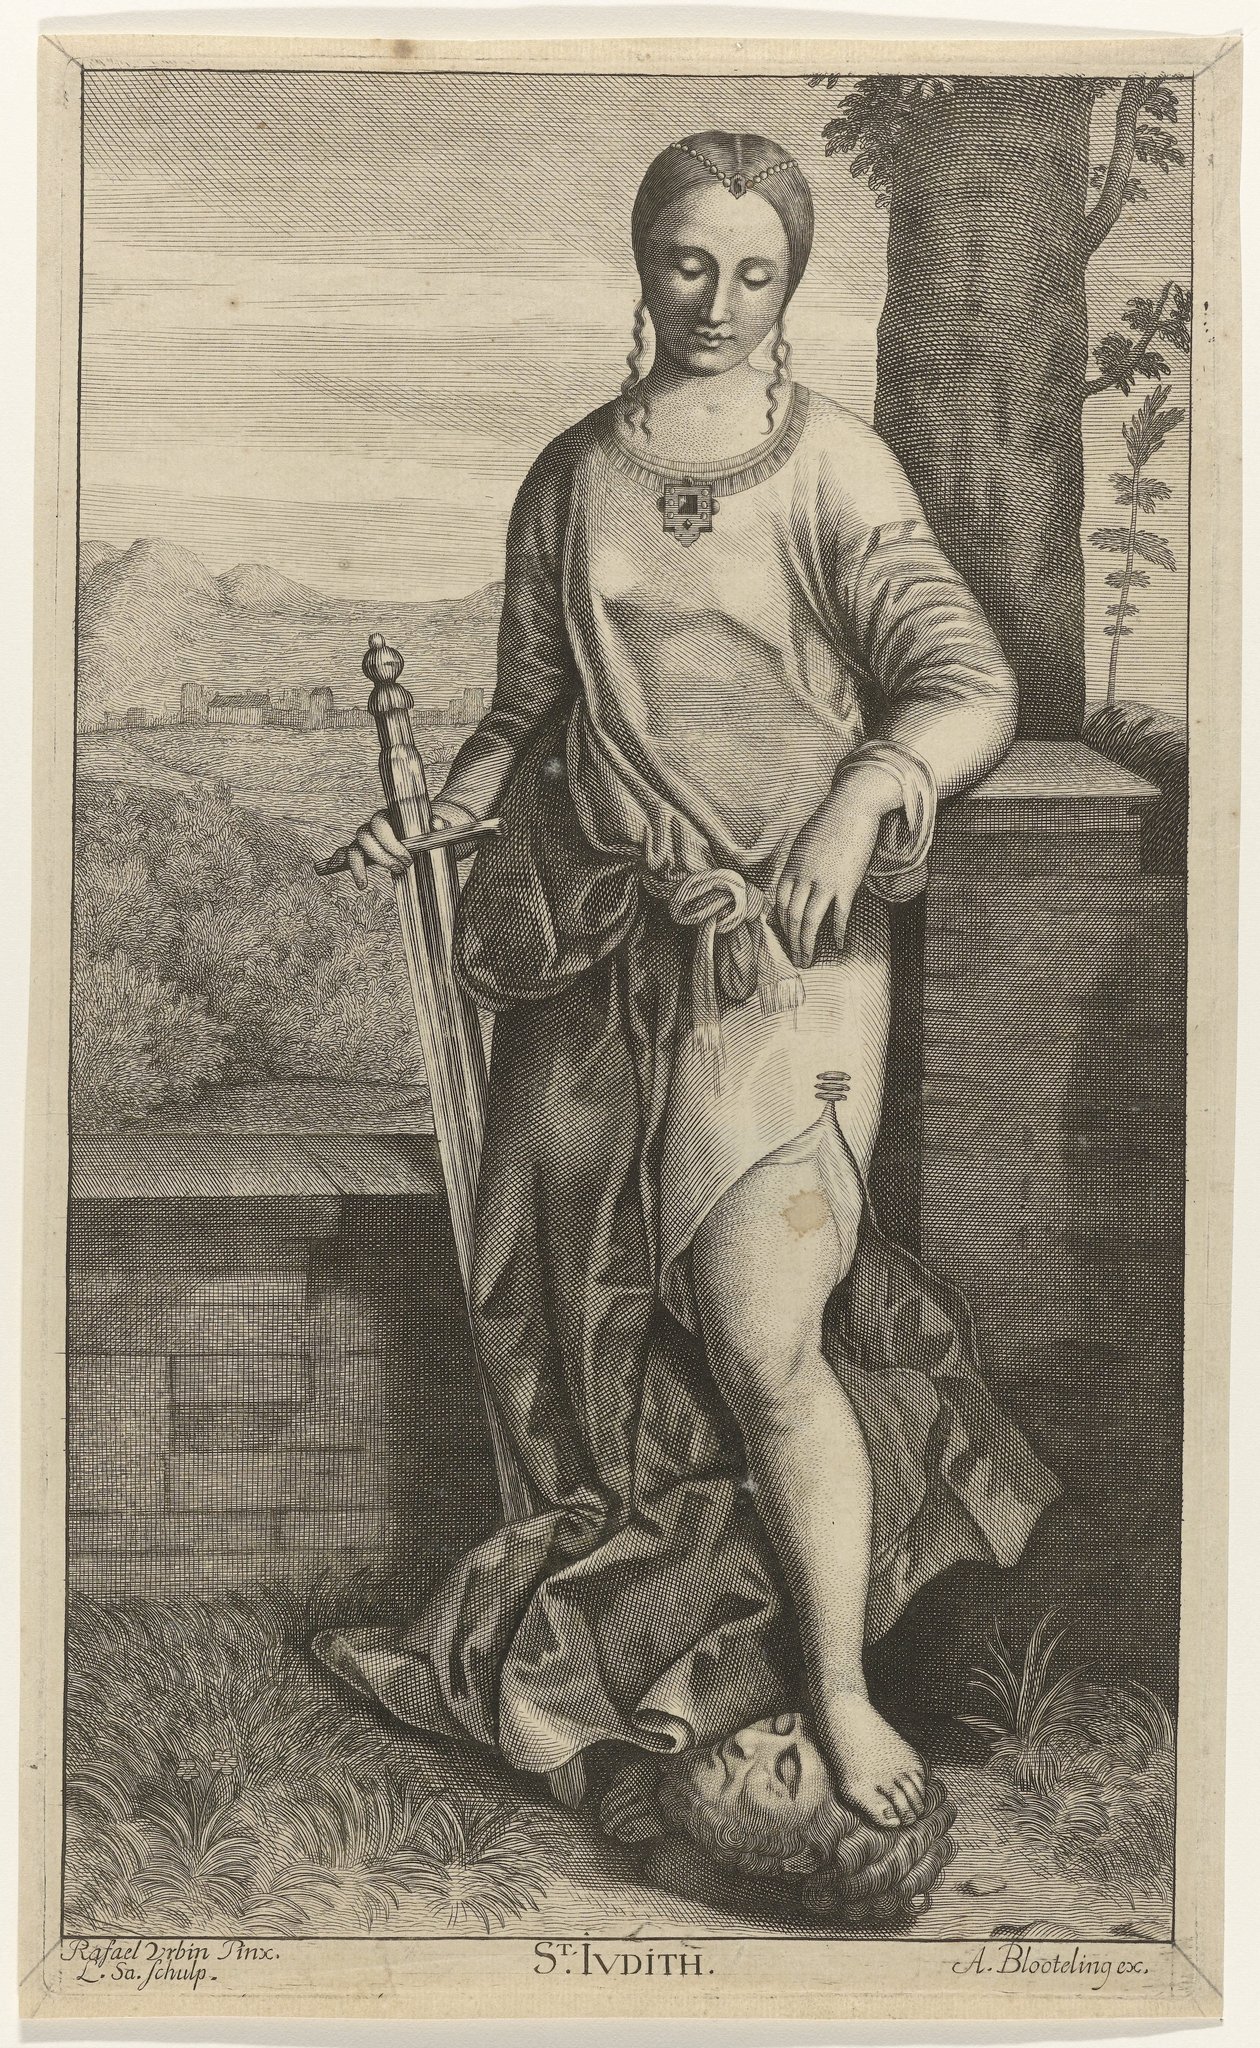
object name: print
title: H. Judit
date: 1655-1690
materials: paper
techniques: engraving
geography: amsterdam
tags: judith and holofernes (judith 8-16)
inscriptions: collector's mark: Lugt 2228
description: Judit, staande met het zwaard in haar hand en het door haar afgehouwen hoofd van Holofernes onder de voet. Op de achtergrond achter een muur een landschap.